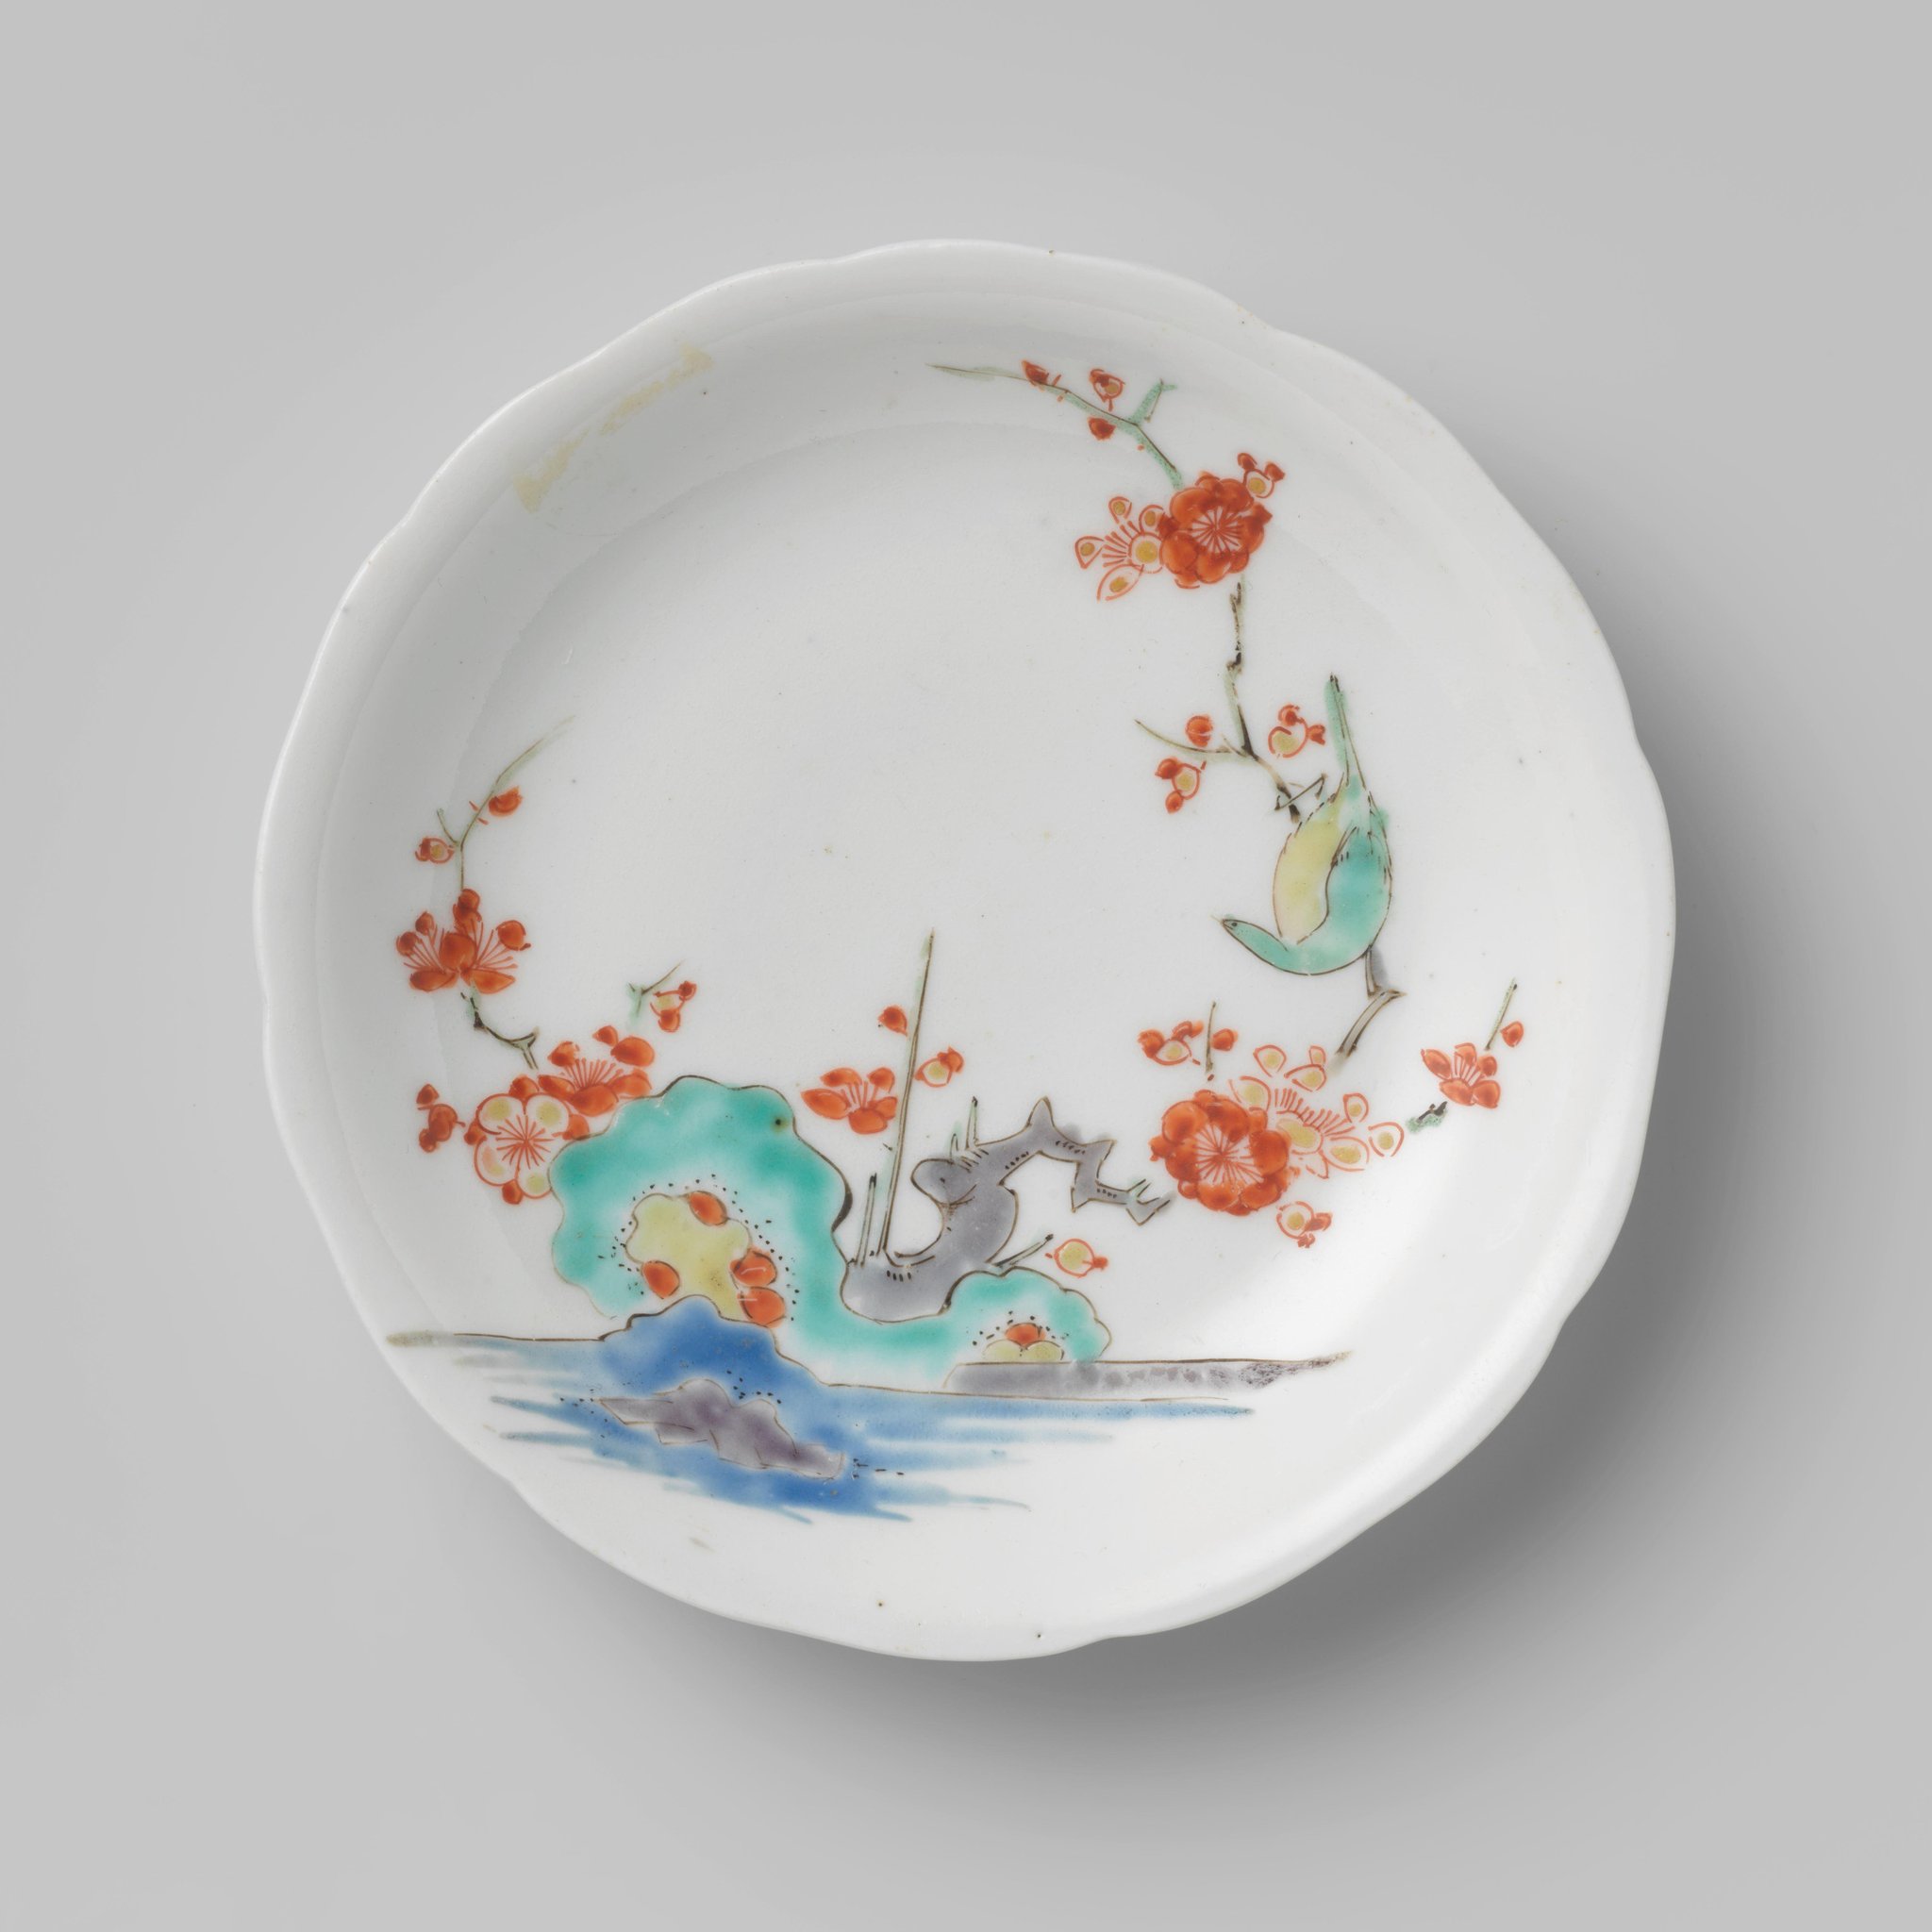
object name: platter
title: Lobed saucer with flower spray and bird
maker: Anonymous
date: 1670-1700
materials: glaze, paint, porcelain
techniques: firing, turning, vitrification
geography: arita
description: Gelobde schotel van porselein, beschilderd op het glazuur in blauw, rood, groen, geel, aubergine en zwart, met op de kop een vogel met chrysanttakken, op de schotel een vogel in een prunustak bij rotsen en water. Kop hoort waarschijnlijk niet bij schotel, gezien het verschil in de kleuren rood en geel. Kakiemon-stijl.